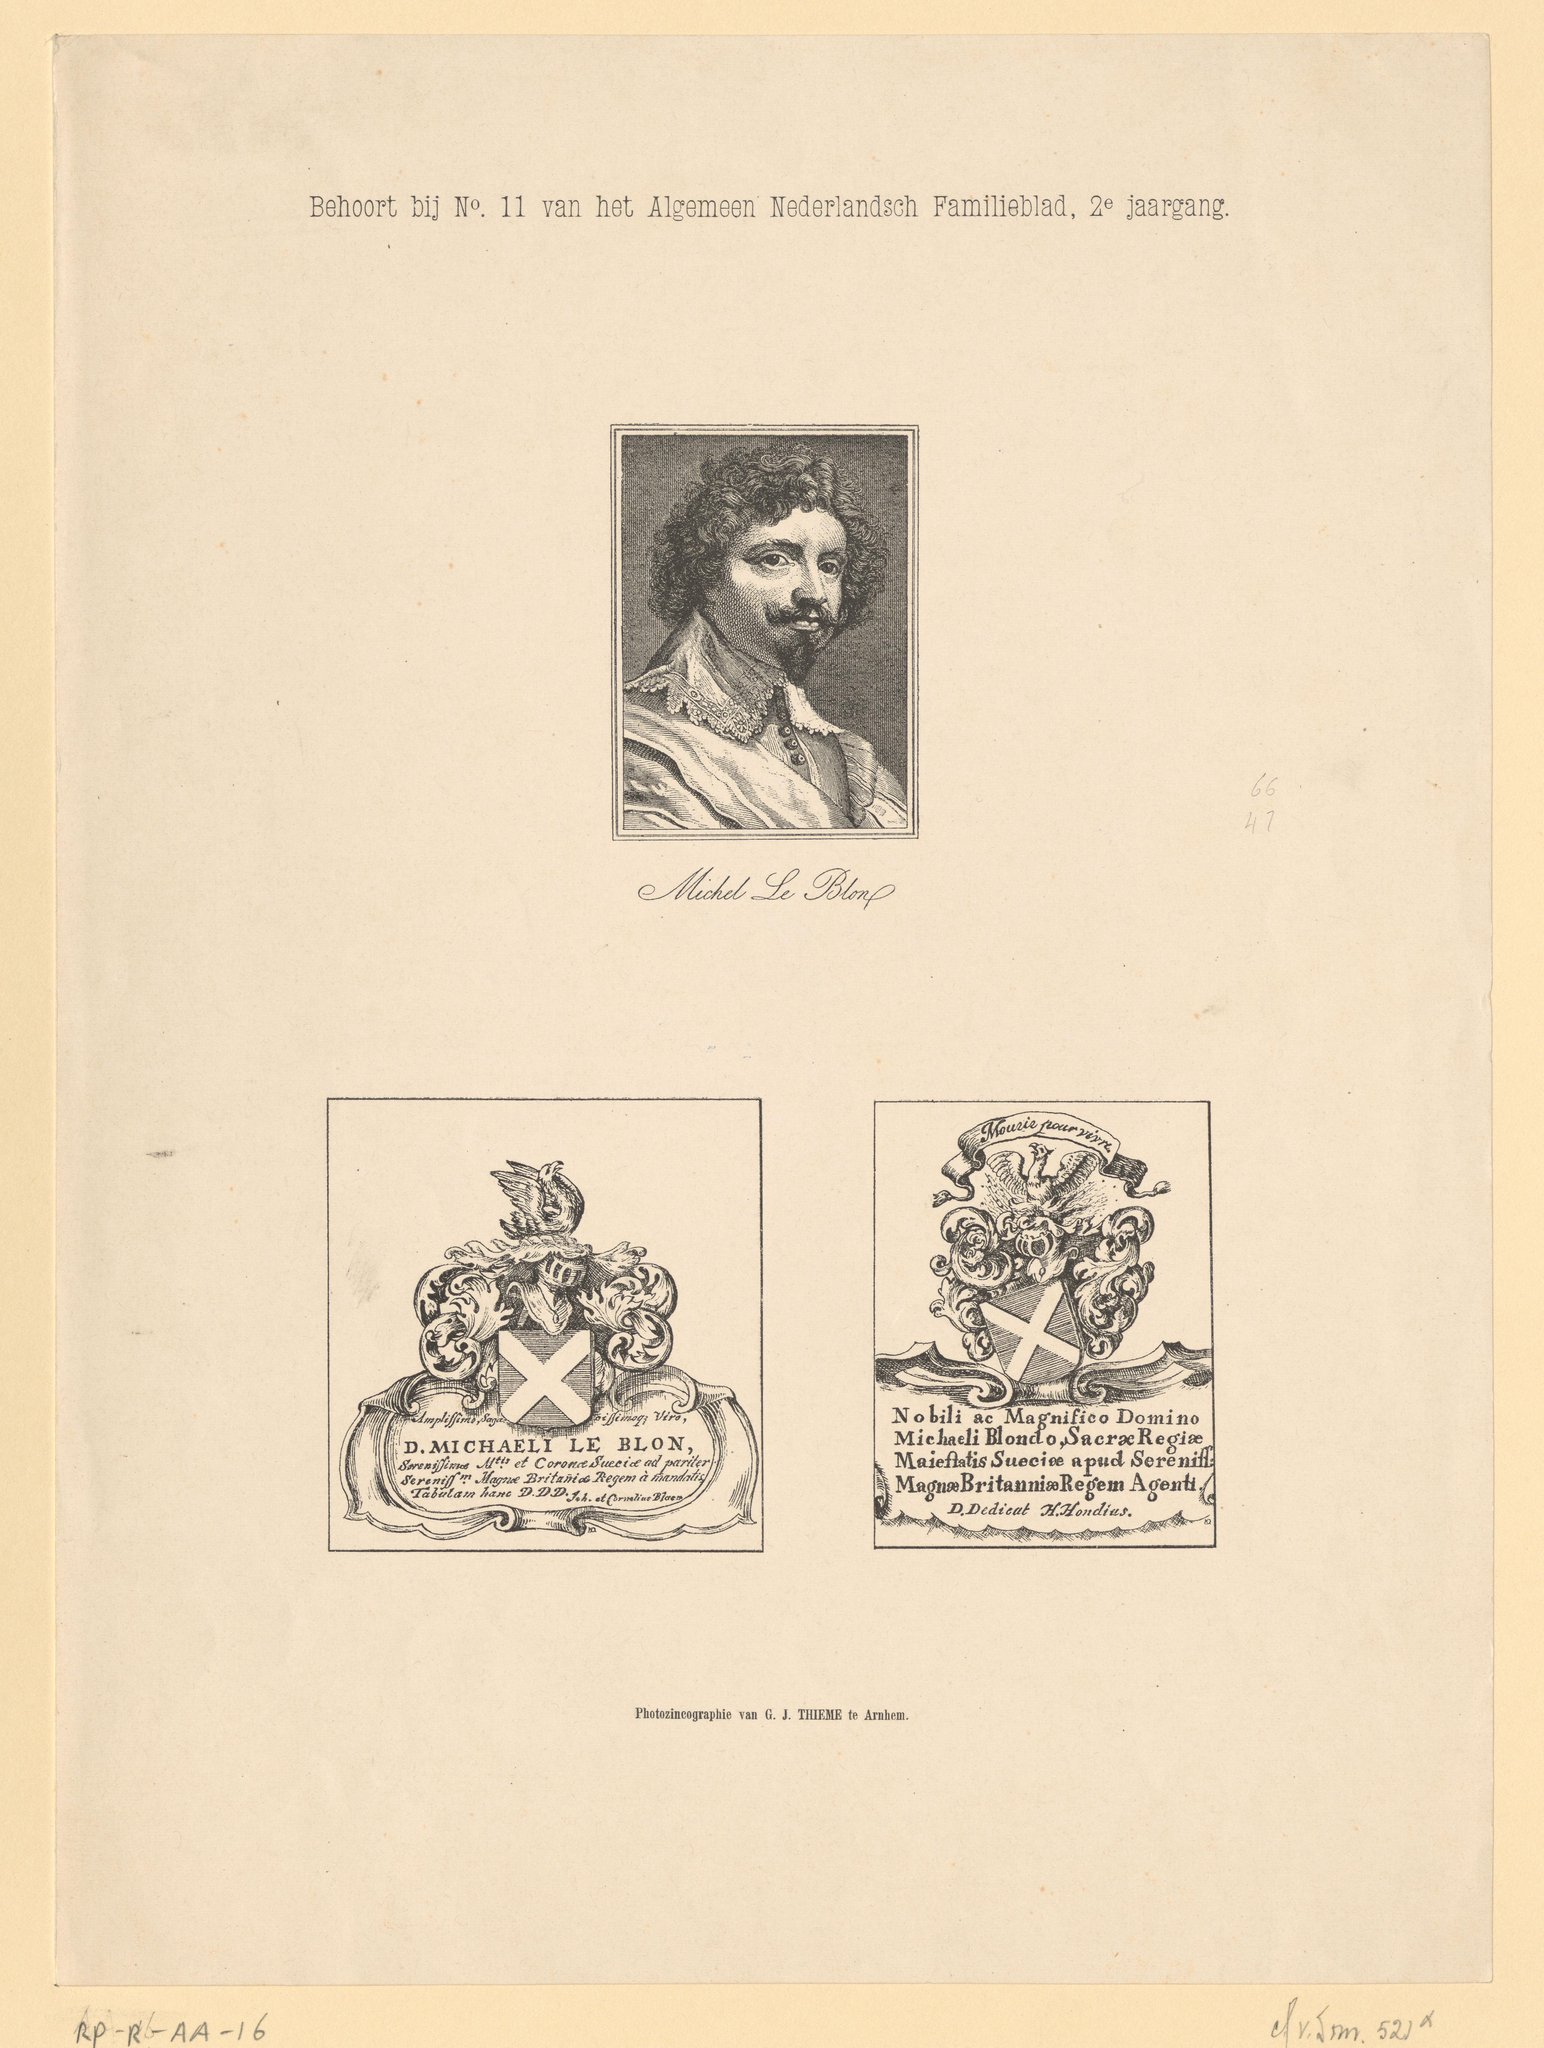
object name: reproduction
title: Portret van Michiel le Blon en twee keer het wapenschild van Le Blon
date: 1885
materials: paper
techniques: photo-zincography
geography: arnhem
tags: amsterdam, print maker, michiel le blon, historical persons, portrait, self-portrait of graphic artist, armorial bearing, heraldry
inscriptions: inscription: ‘V.v Oyen 27/8-88’, collector's mark: Lugt 2228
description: Prent gebruikt als bijlage bij: Algemeen Nederlandsch familieblad 2 (1885), nr. 11